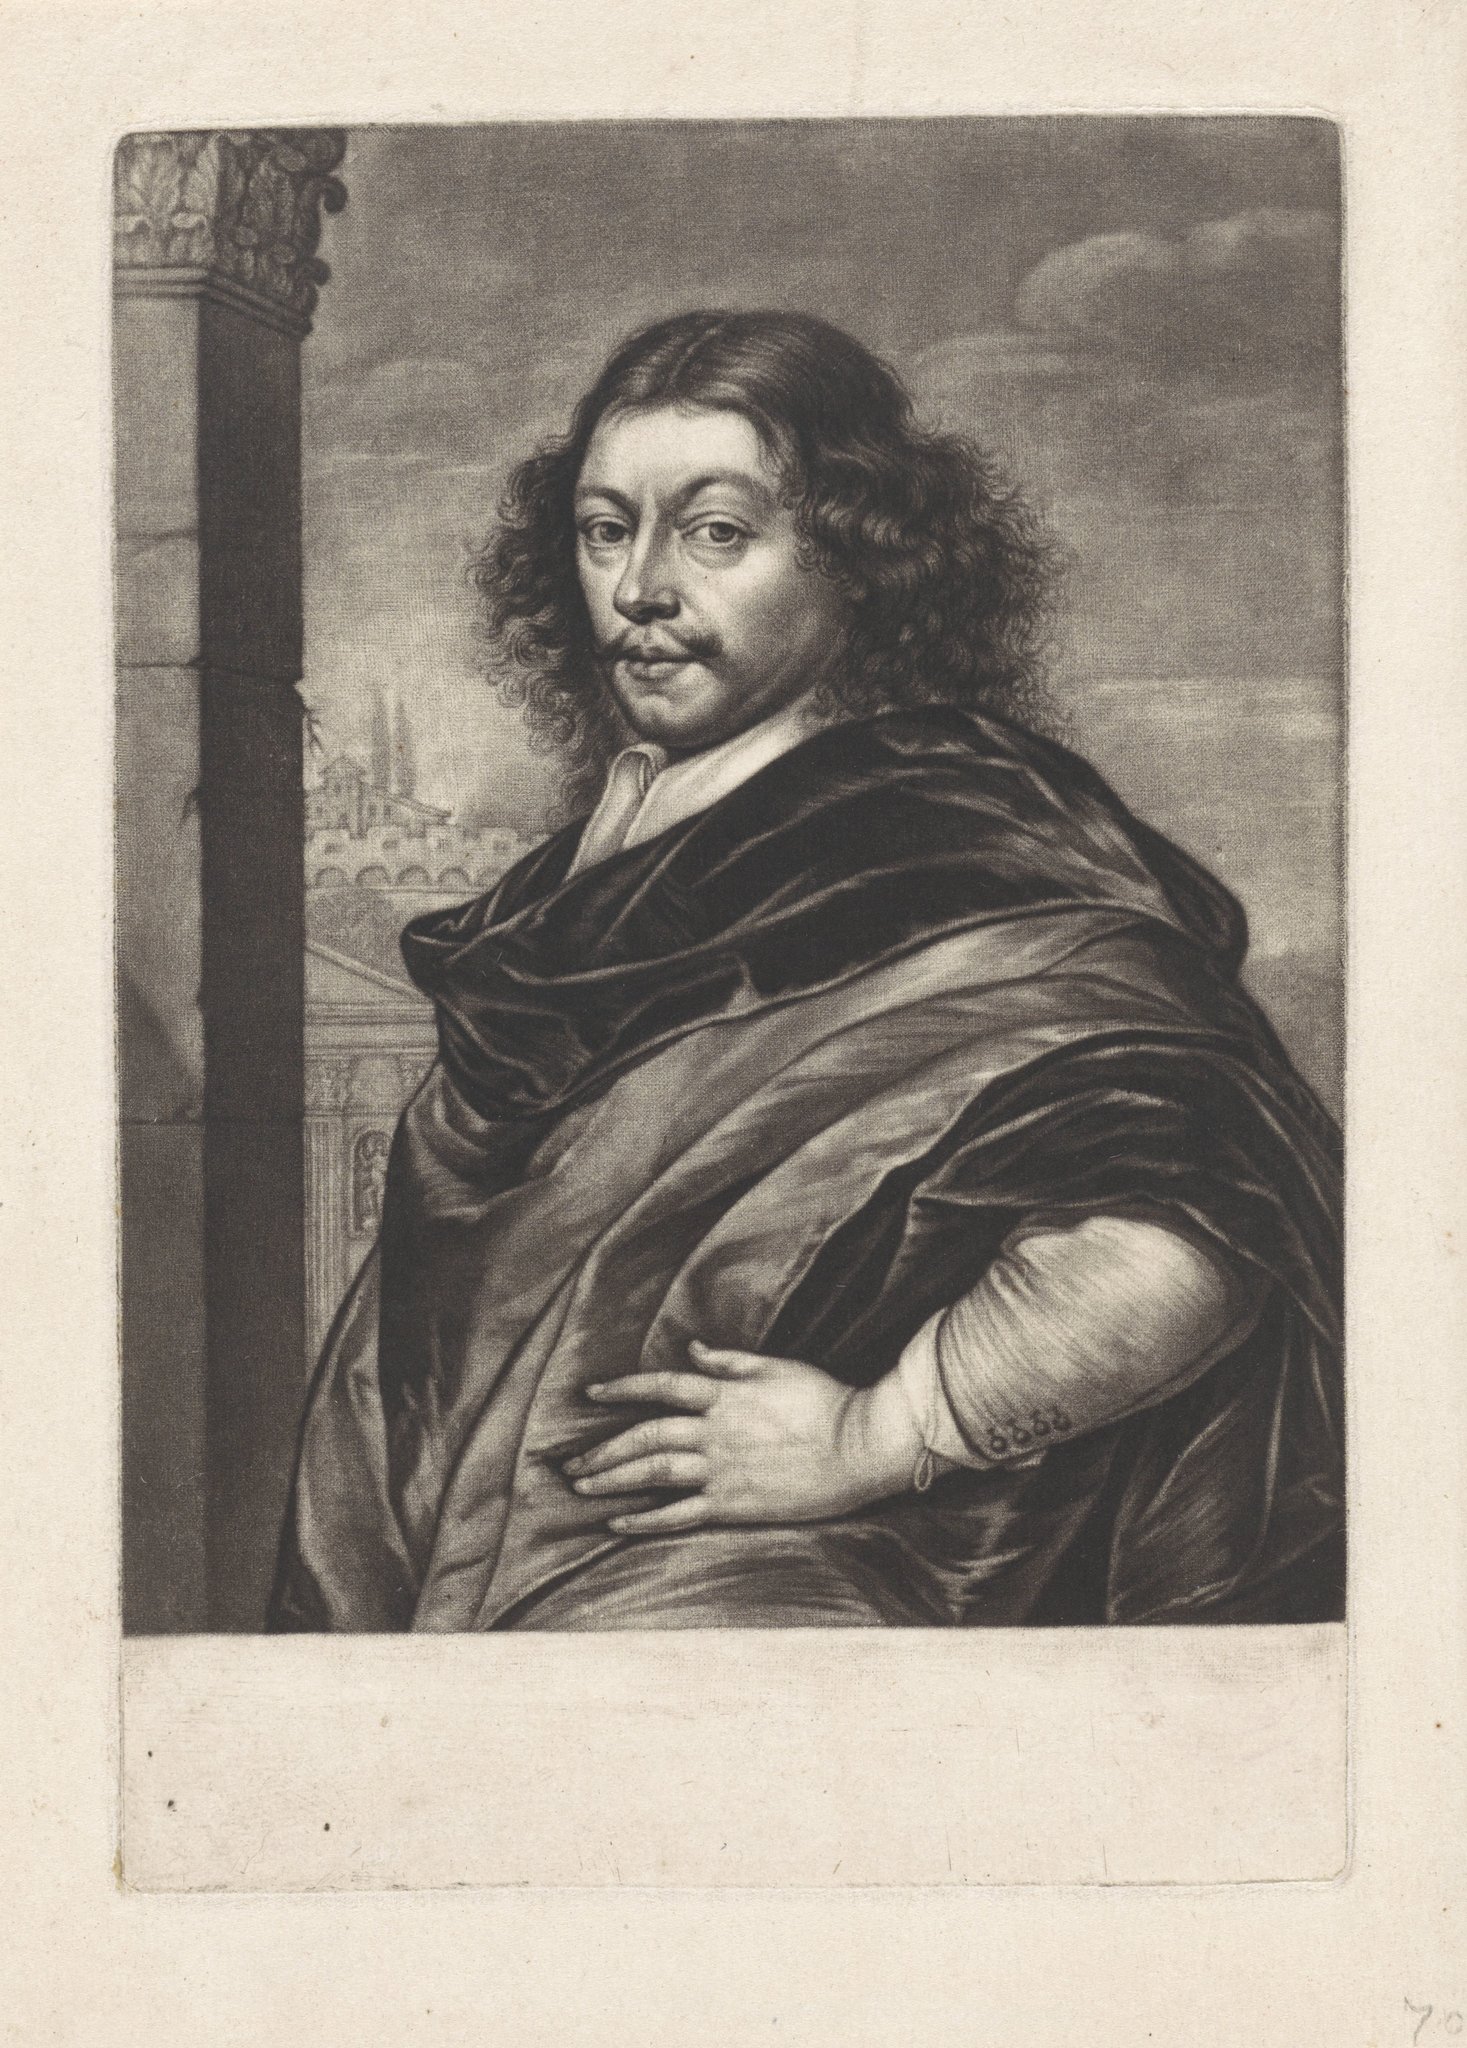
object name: print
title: Portret van Frans van Mieris (I)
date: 1655-1690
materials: paper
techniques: mezzotint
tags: leiden, painter, print maker, draughtsman, frans van mieris (i), portrait, self-portrait of painter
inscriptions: collector's mark: Lugt 240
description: Portret van de schilder Frans van Mieris met de hand in de zij. Op de achtergrond de contouren van een stad.